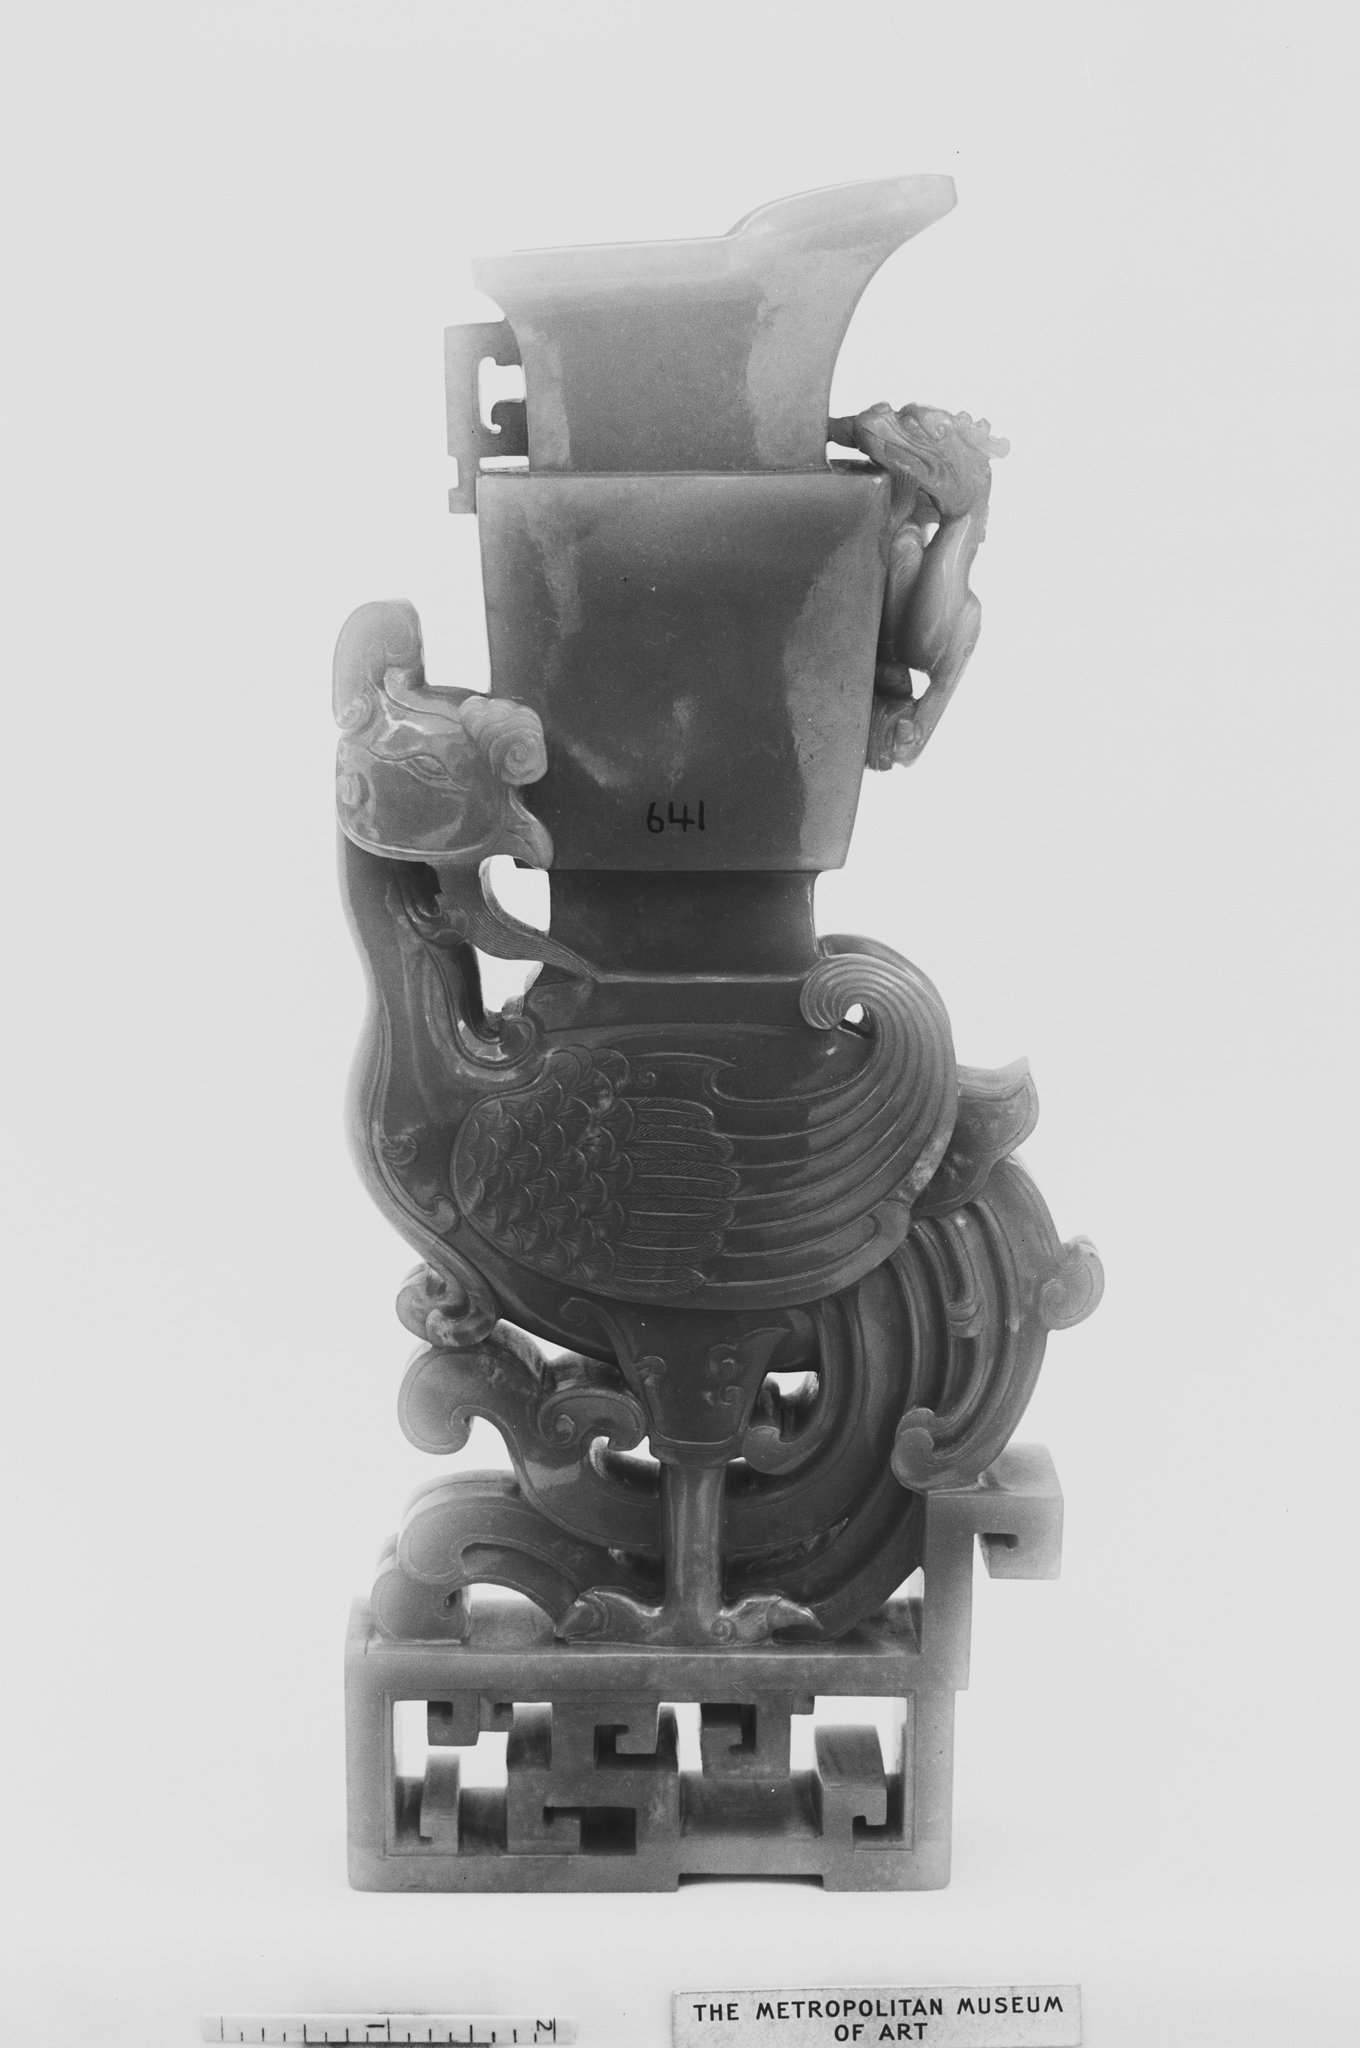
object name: vase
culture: chinese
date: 1736-1795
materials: jade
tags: birds